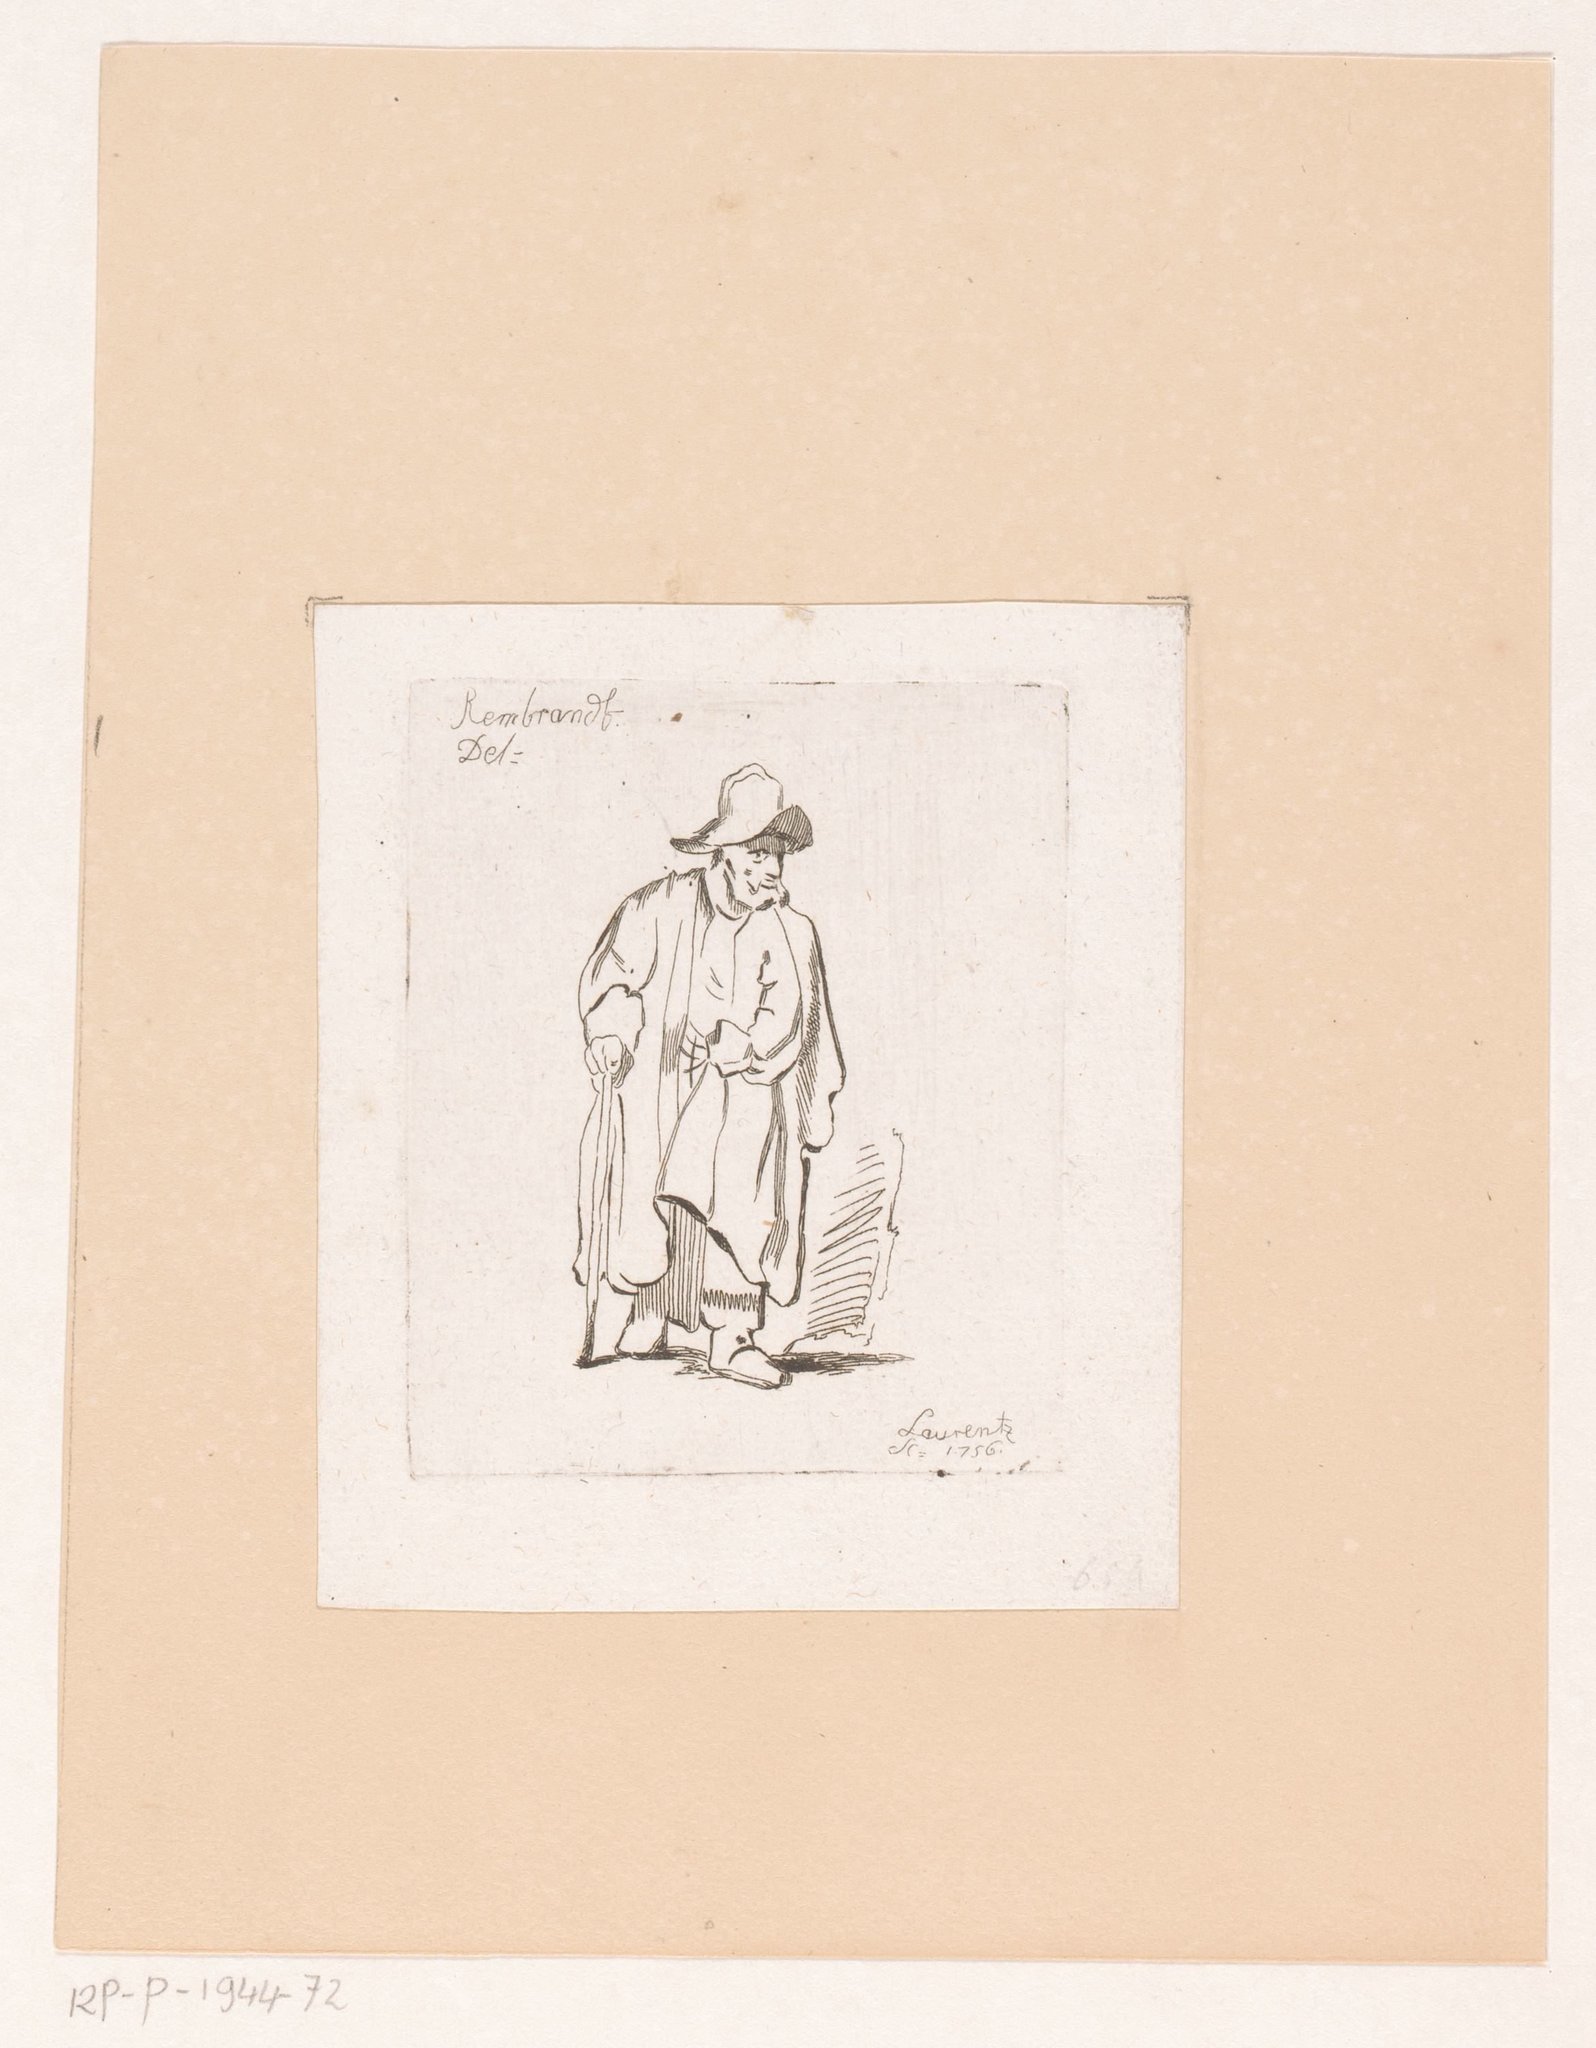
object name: print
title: Oude man met wandelstok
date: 1756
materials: paper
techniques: etching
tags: walking-stick, staff, old man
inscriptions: collector's mark: Lugt 240, collector's mark: Lugt 2228